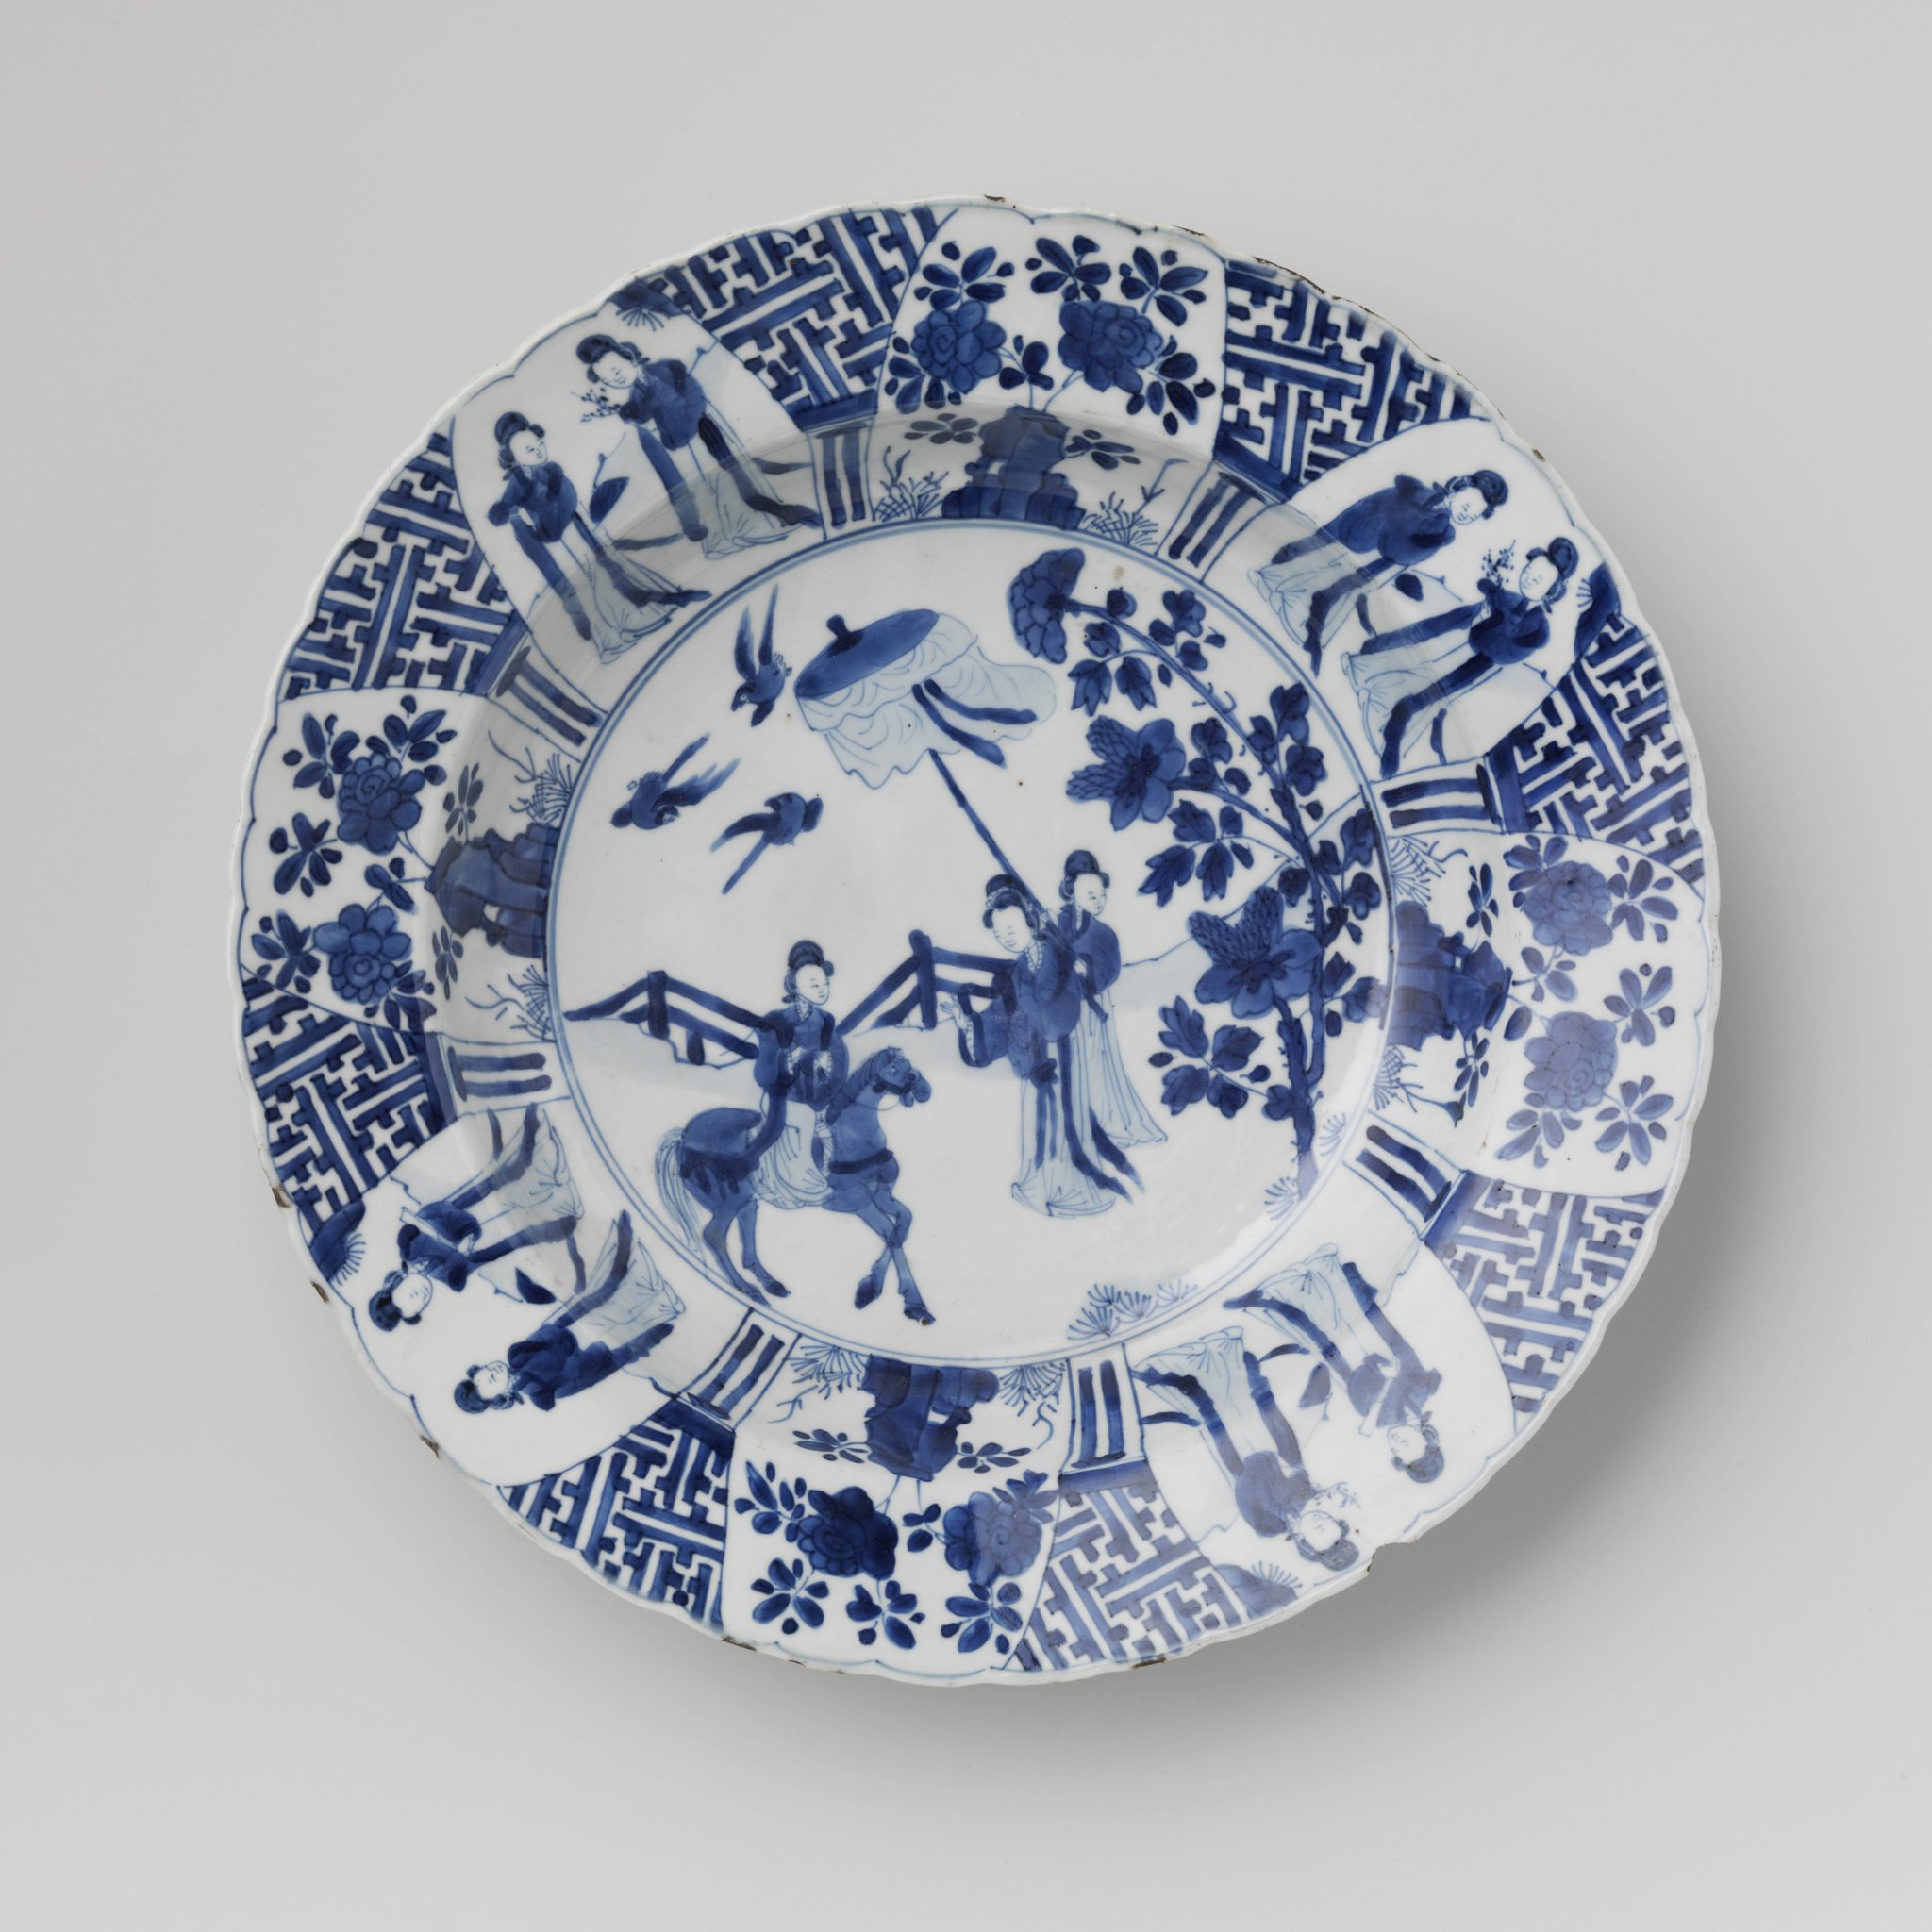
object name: platter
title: Dish with women in a fenced garden and flowering plants near a rock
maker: Anonymous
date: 1680-1720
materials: cobalt, glaze, paint, porcelain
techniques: firing, turning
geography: china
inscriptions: mark: ‘大 清 康 熙 年 製 dà qīng Kāngxī nián zhì’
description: Diepe schotel van porselein met een gelobde rand, beschilderd in onderglazuur blauw. Op het plat in een medaillon een vrouw (lange lijs) op een paard in een omheinde tuin. Tegenover staat een vrouw, haar hand geheven in een groetend gebaar. Achter haar een bediende met een parasol. Boven hen vliegen drie vogels. De wand en rand met acht gelobde vakken met afwisselend twee vrouwen in een omheinde tuin of bloeiende planten bij een rots. Tussen de cartouches een swastika-patroon en strikken. De buitenrand met zes bloemranken. De buitenwand met ruyi-motieven gescheiden door verticale strepen. Gemerkt op de onderzijde met het zes-karaktermerk van keizer Kangxi in een dubbele cirkel. Een barst en enkele chips in de rand. Blauw-wit.